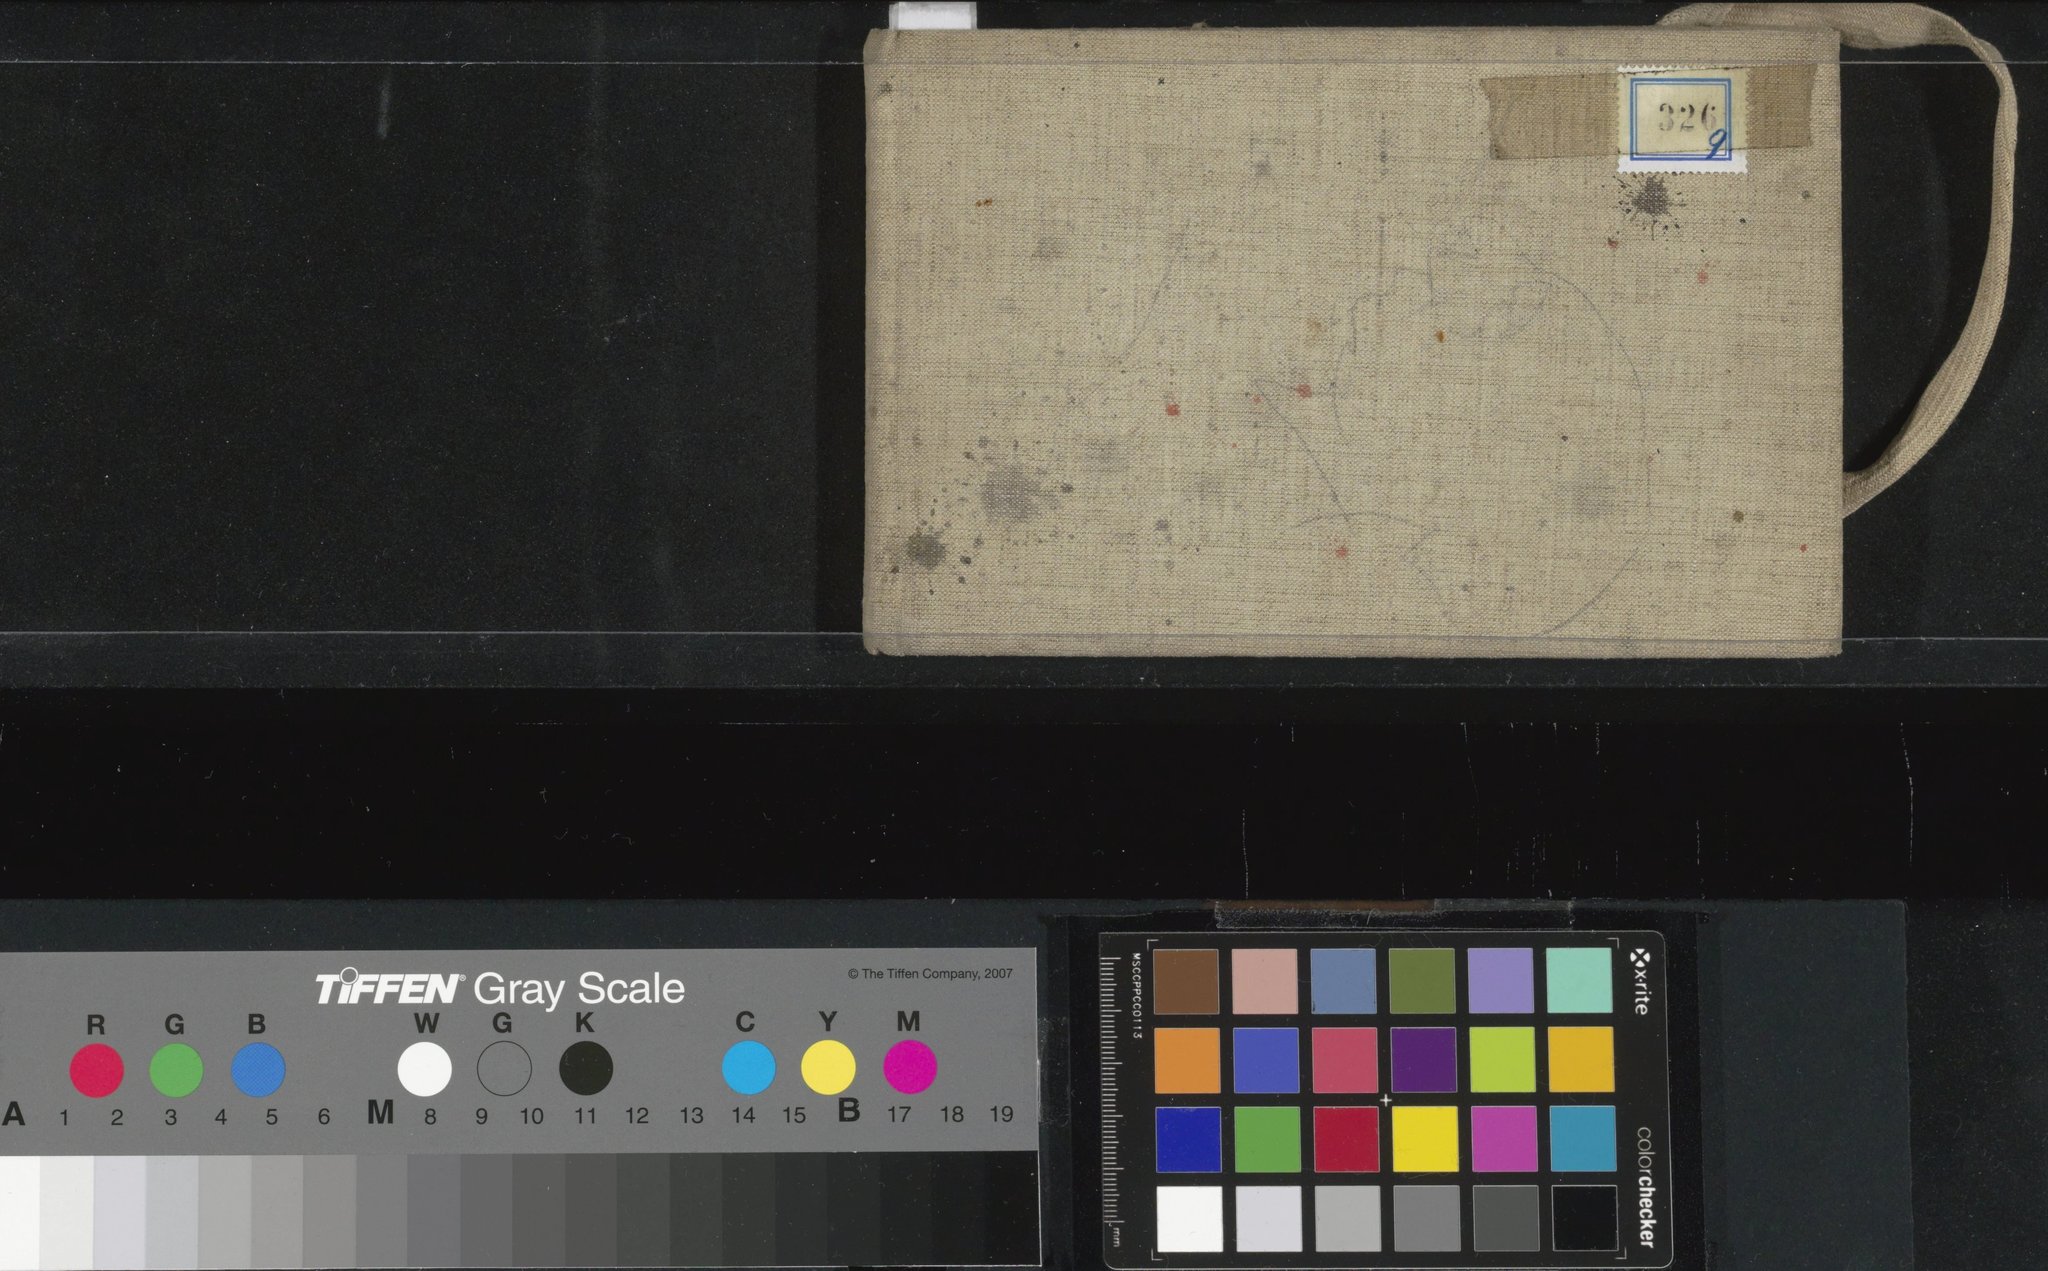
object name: sketchbook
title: Schetsboek met 43 bladen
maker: anton mauve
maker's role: draughtsman, painter, print maker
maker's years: 1838-1888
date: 1848-1888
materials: cardboard, chalk, paint, linen, paper, pencil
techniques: brush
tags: landscapes, herding, herdsman, herdswoman, shepherd, shepherdess, cowherd, etc., cultivation ~ agriculture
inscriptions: workshop stamp: ‘Atelier/ A Mauve’, collector's mark: Lugt 2228a, label: ‘326/ 9’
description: Schetsboek bestaande uit 43 bladen met voornamelijk landschappen, weilanden met vee, spittende en ploegende boeren en herders met schapen. Op de voor- en achterzijde van de boekomslag potloodtekeningen van een karikaturale mannenkop.